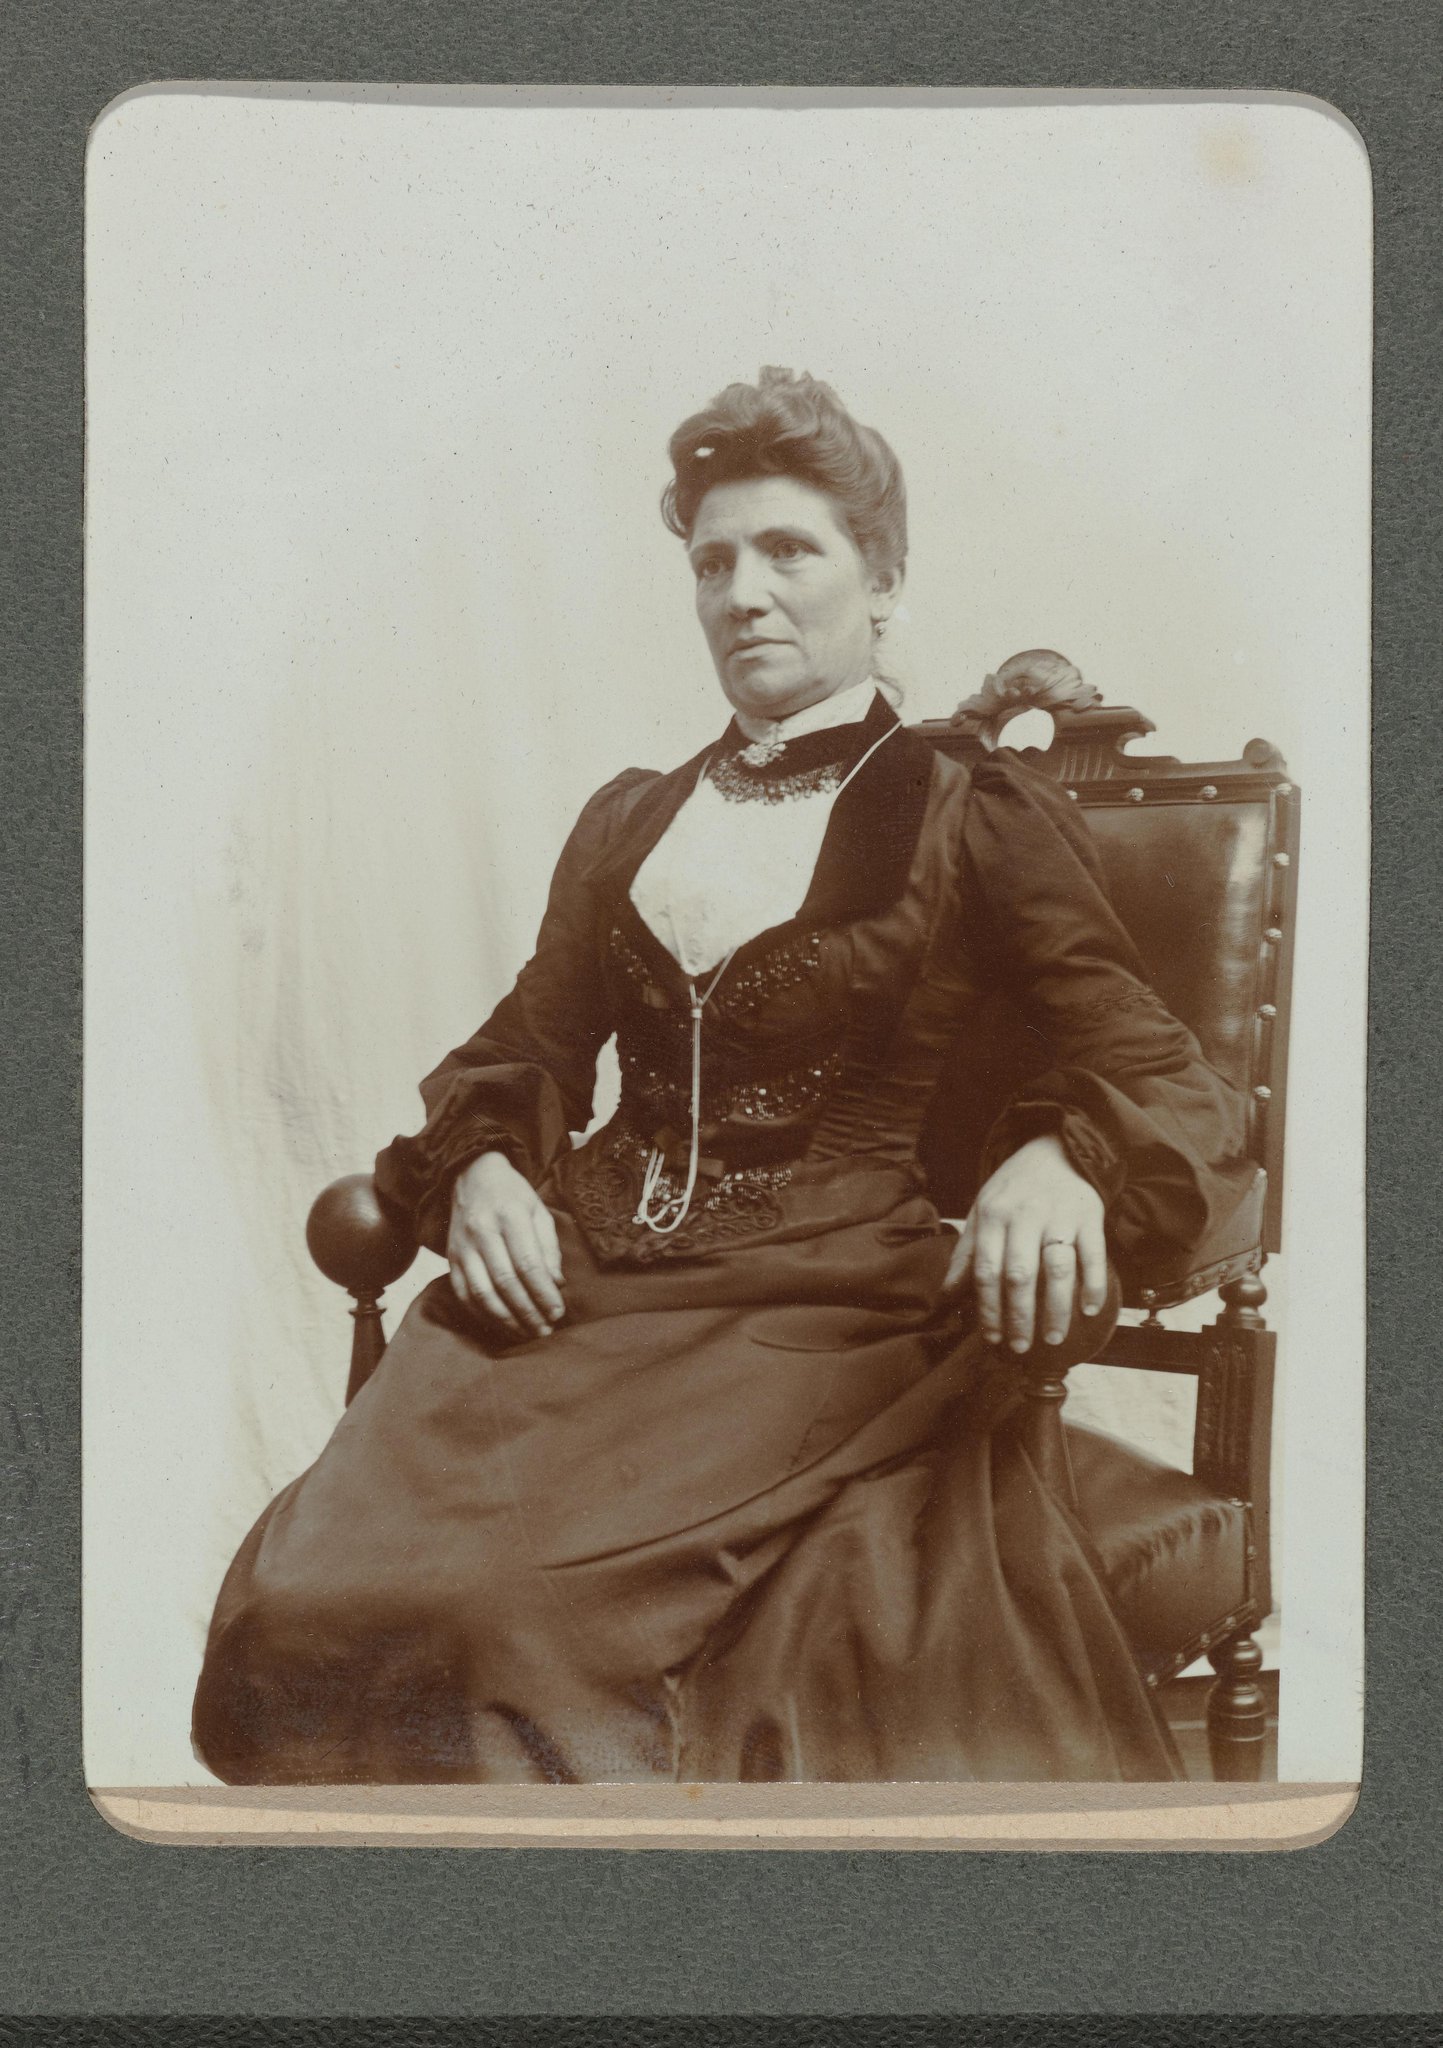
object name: photograph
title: Portret van een zittende vrouw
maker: christiaan otto roelofs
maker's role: fotograaf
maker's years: 1882-1970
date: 1890-1915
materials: photographic support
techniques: gelatin silver print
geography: netherlands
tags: sitting figure, historical persons - bb - woman